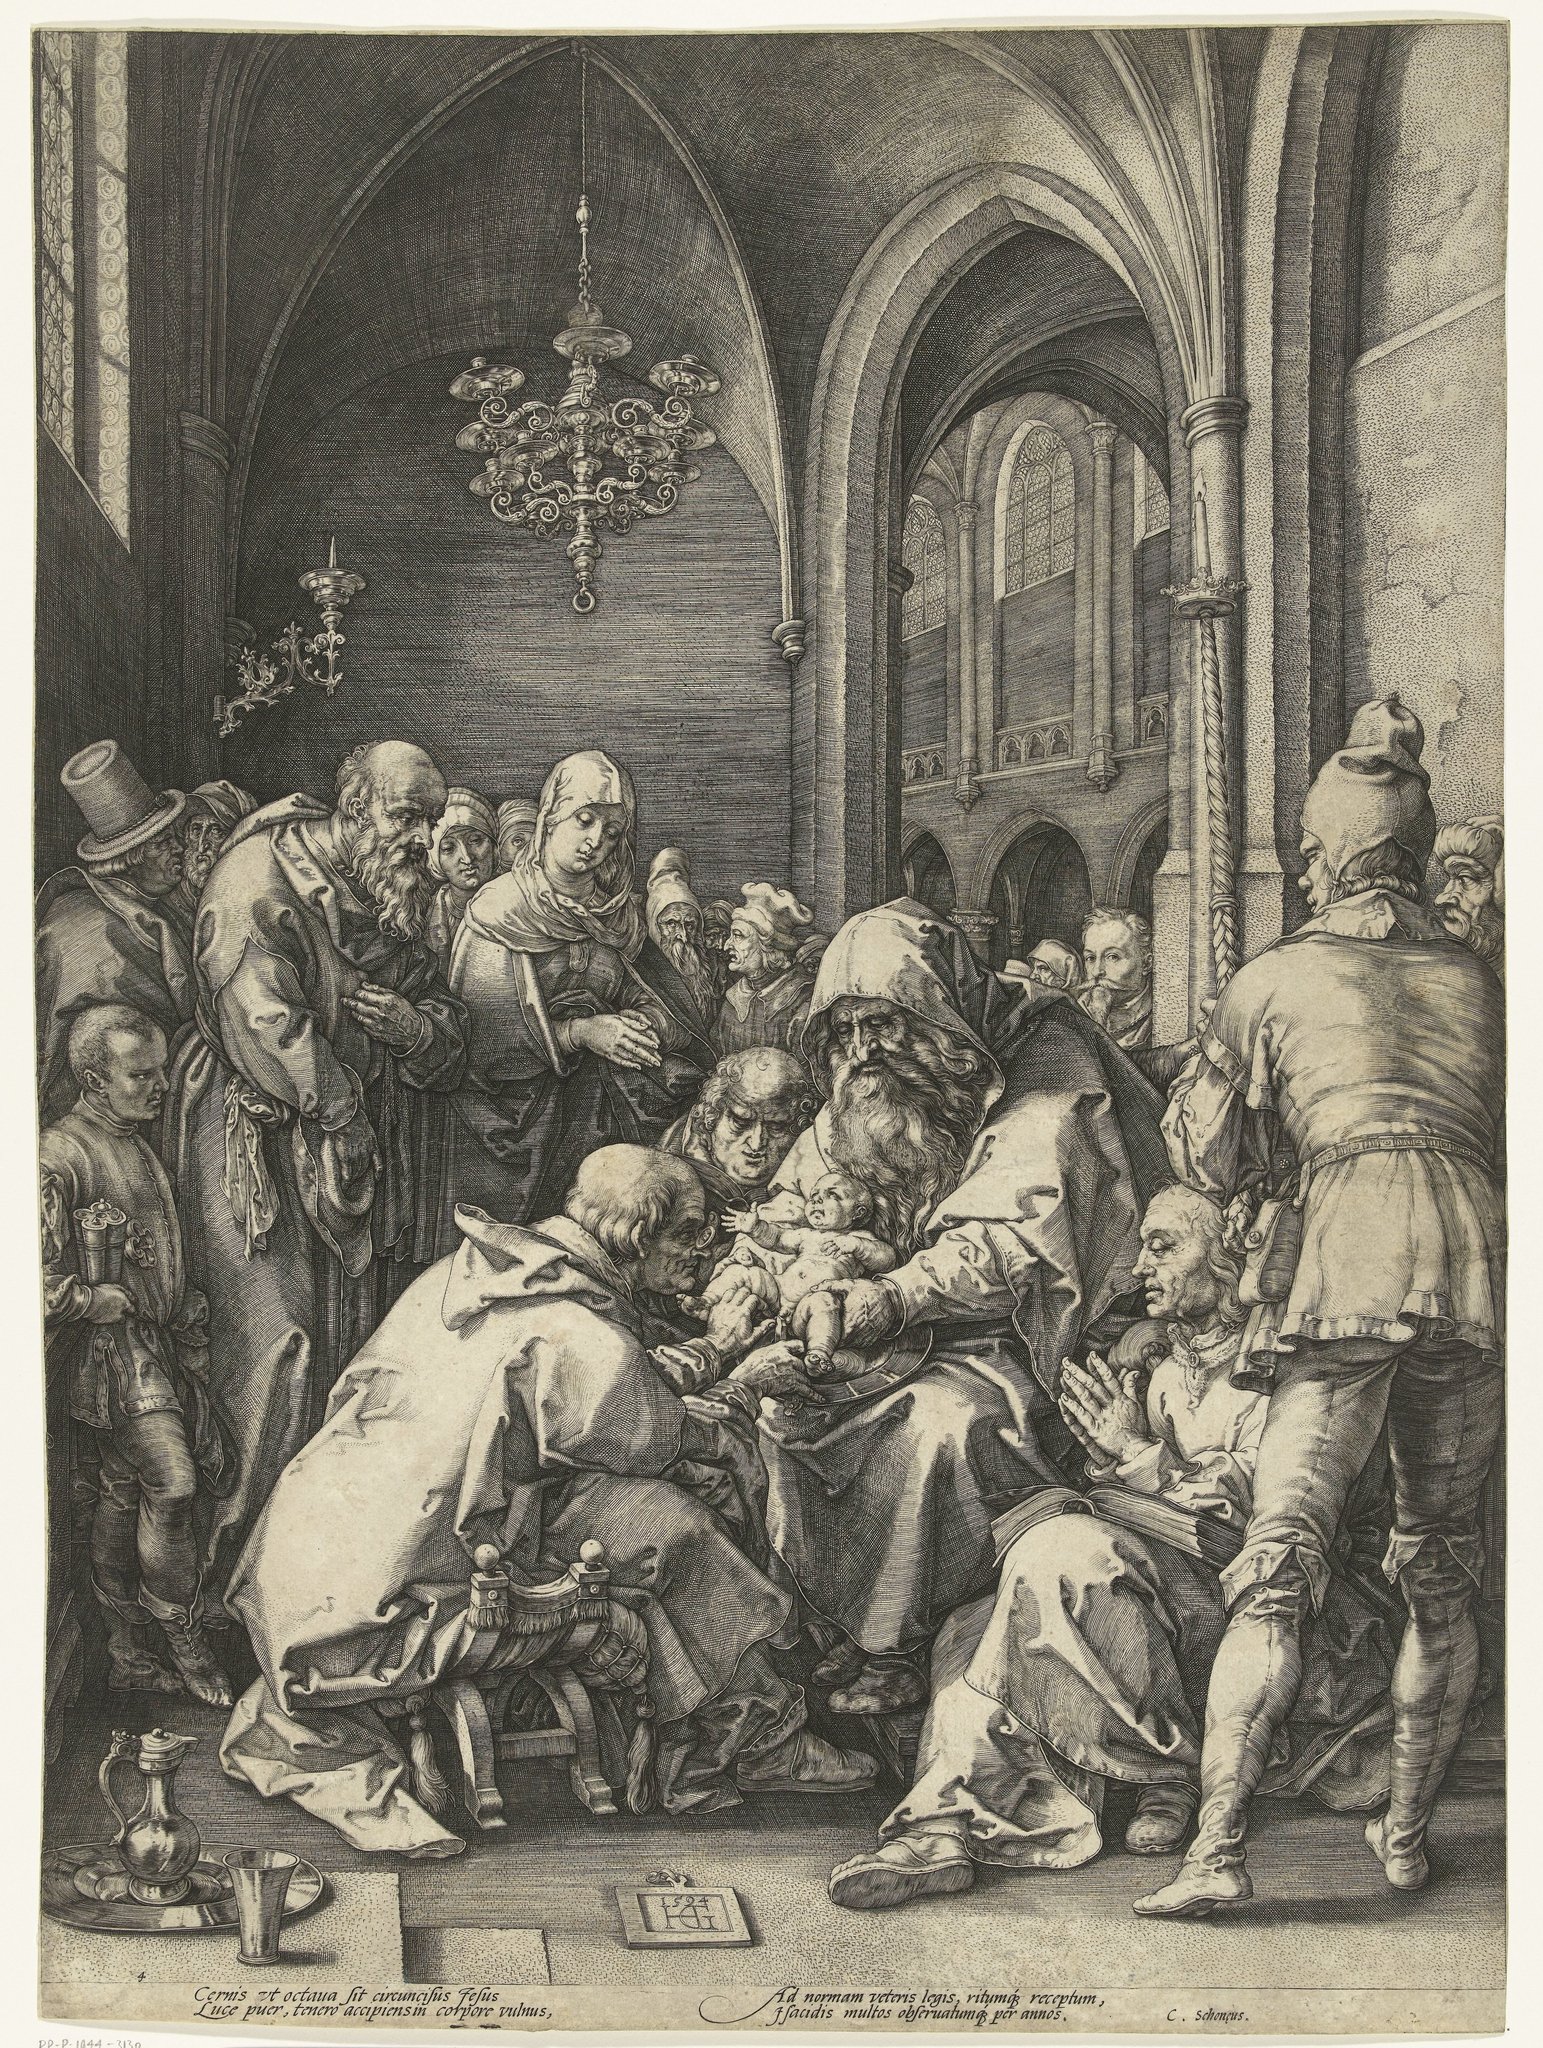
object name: print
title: Het vroege leven van Maria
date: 1594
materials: paper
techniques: engraving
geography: haarlem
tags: circumcision of the christ-child by the priest in the temple (luke 2:21)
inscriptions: collector's mark: Lugt 2228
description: Deze prent is onderdeel van een serie van zes prenten met scènes uit het vroege leven van Maria. Die worden de 'Meesterstukken' genoemd, omdat Goltzius er het werk van verschillende illustere voorgangers in heeft nagebootst.